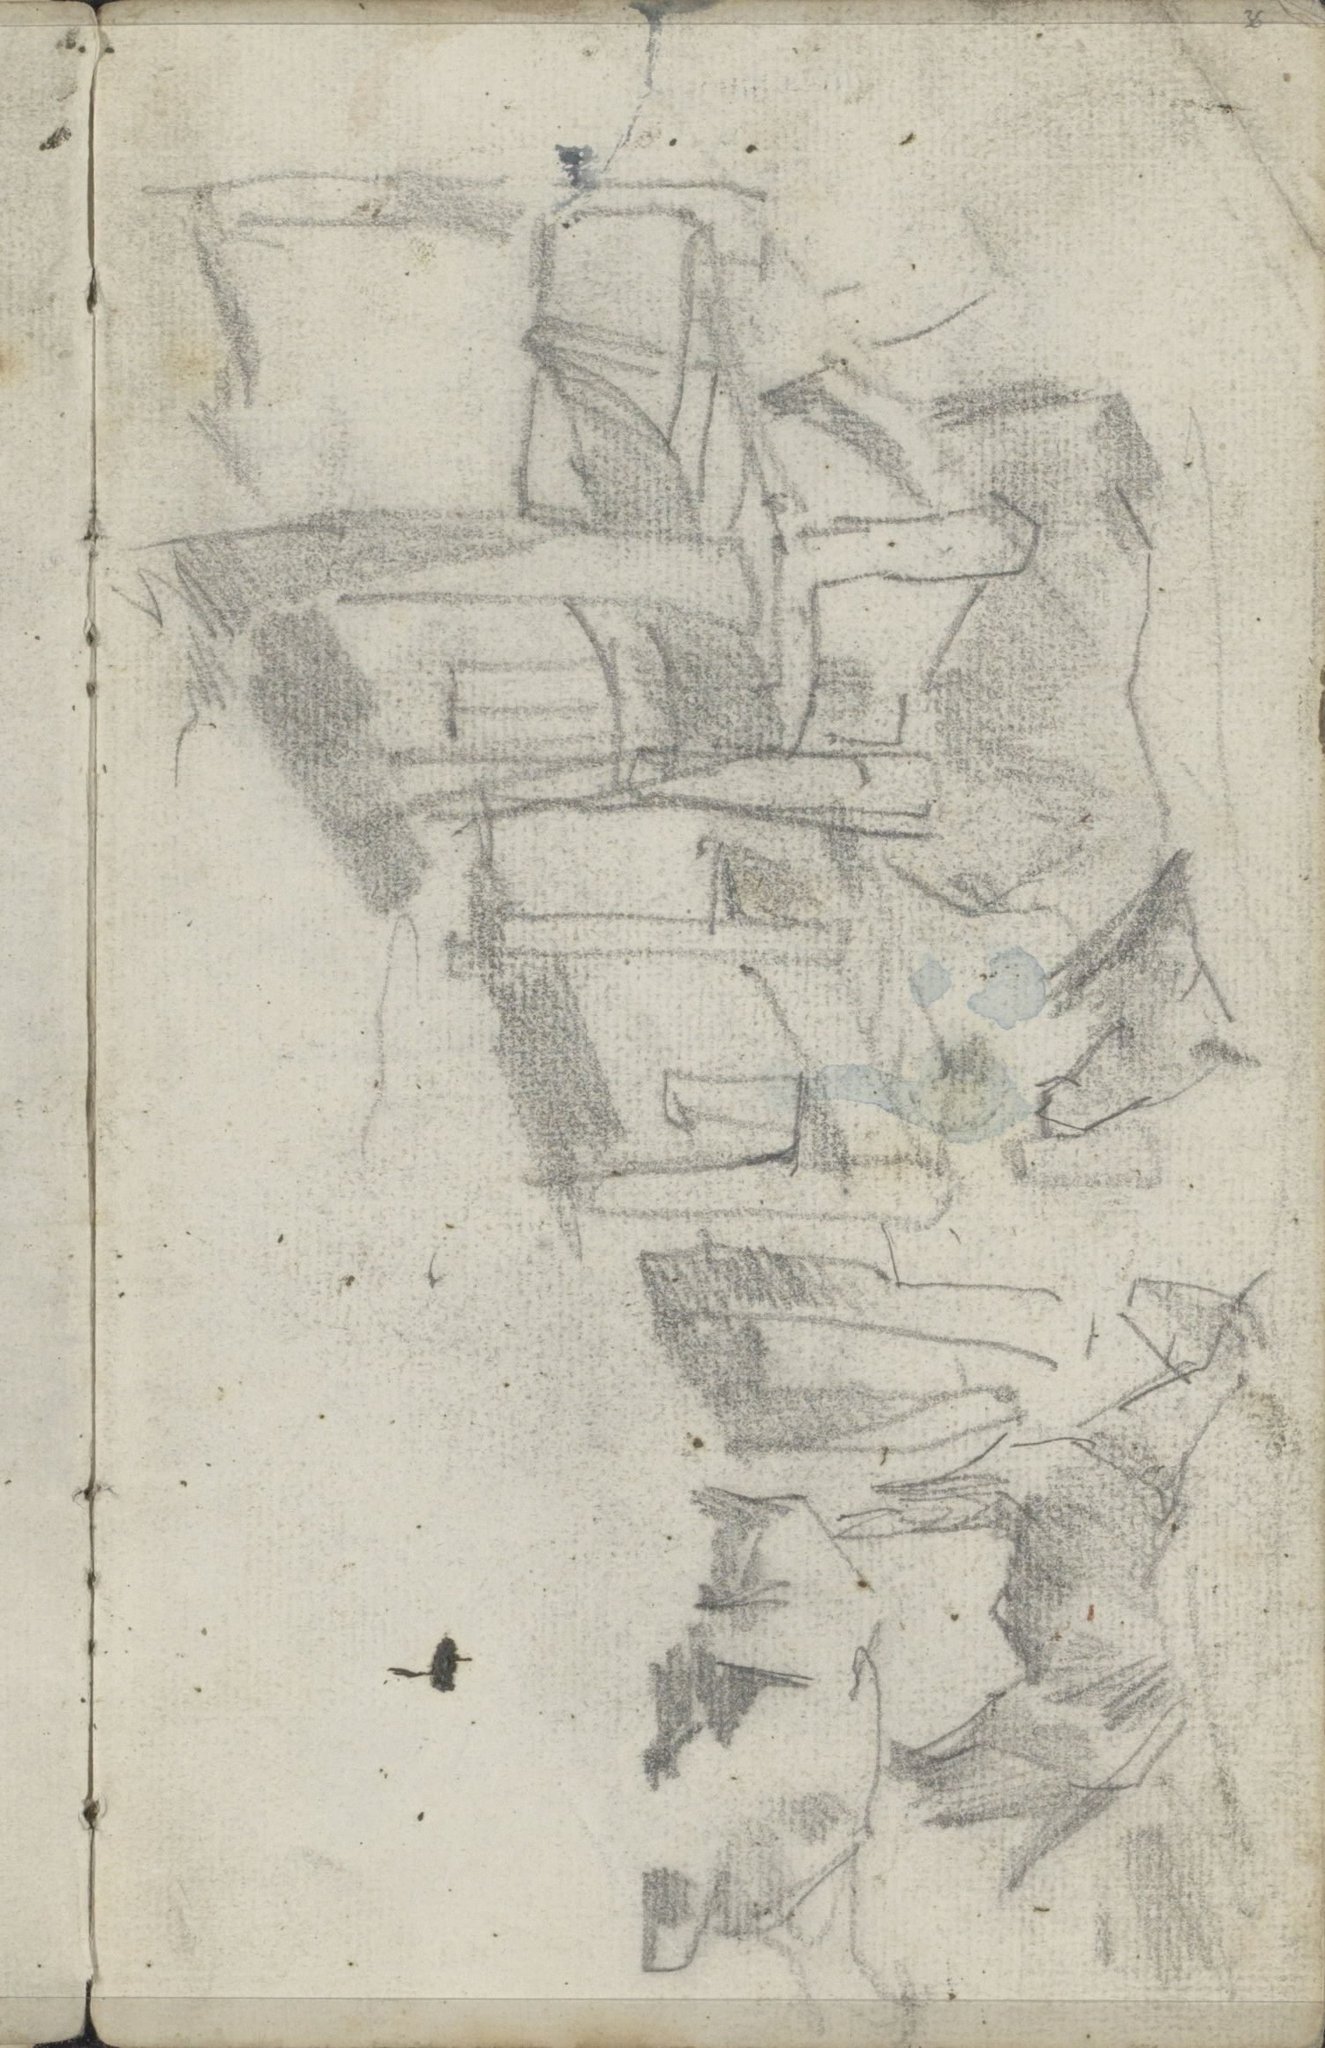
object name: sketchbook leaf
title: Paarden bij een voederbak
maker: george hendrik breitner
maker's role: draughtsman, painter, print maker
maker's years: 1857-1923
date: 1881-1883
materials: paper, pencil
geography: the hague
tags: trough, horse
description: Pagina 36 uit een schetsboek met 27 bladen